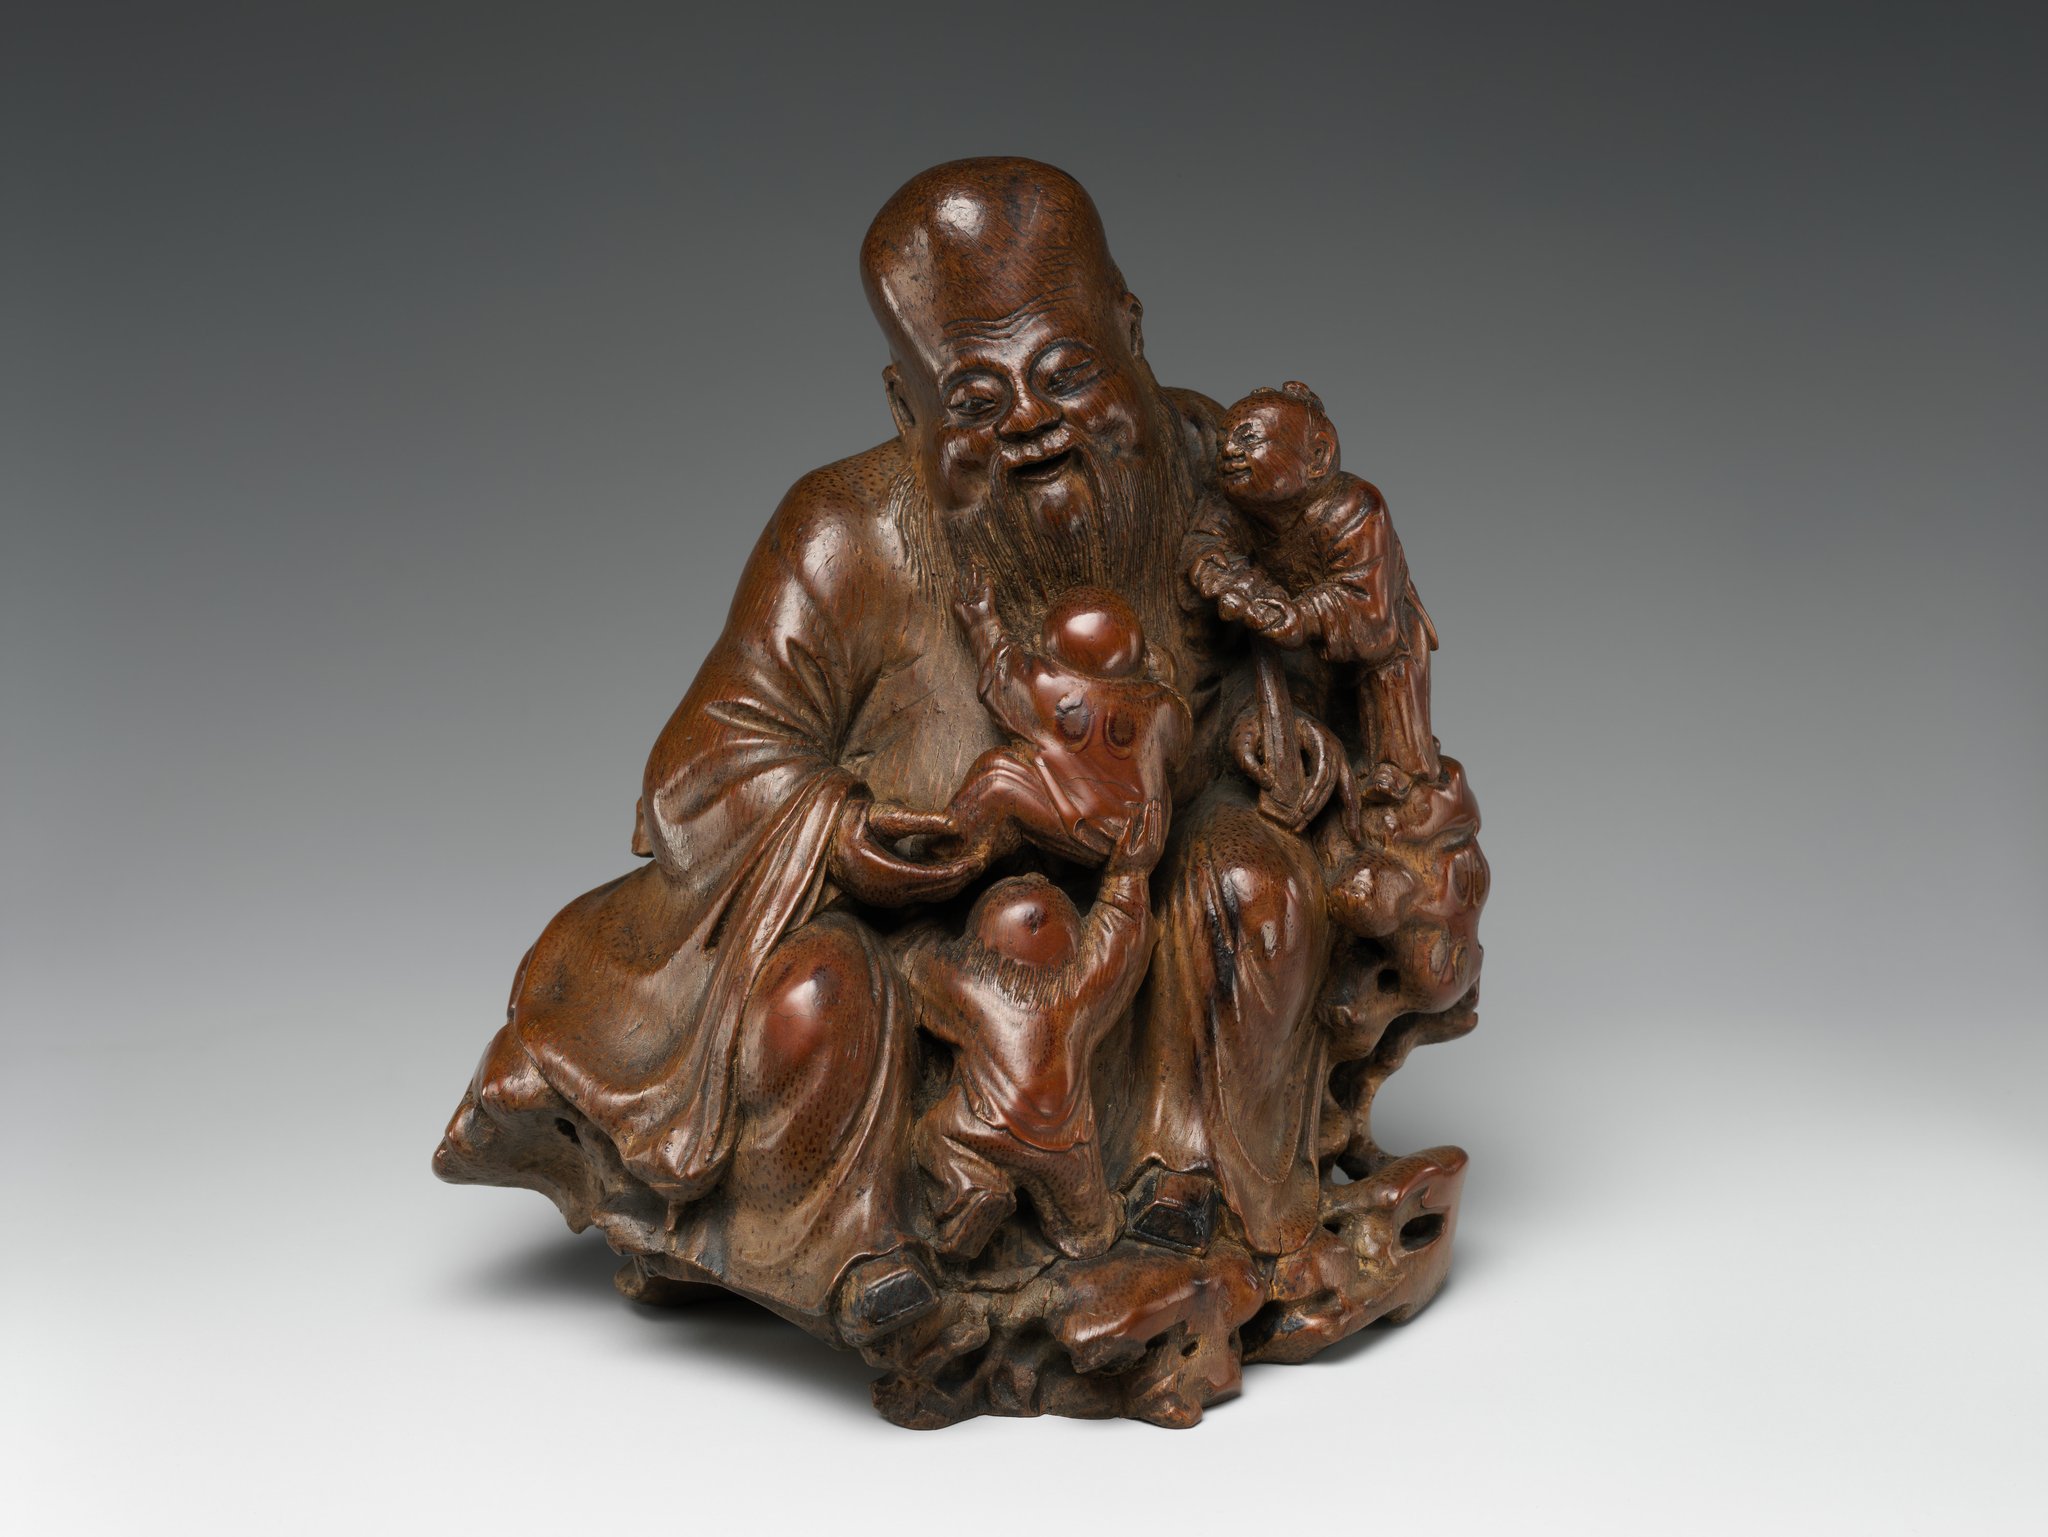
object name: figure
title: God of Longevity (Shoulao) with children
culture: chinese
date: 1701-1800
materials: bamboo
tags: infants,men